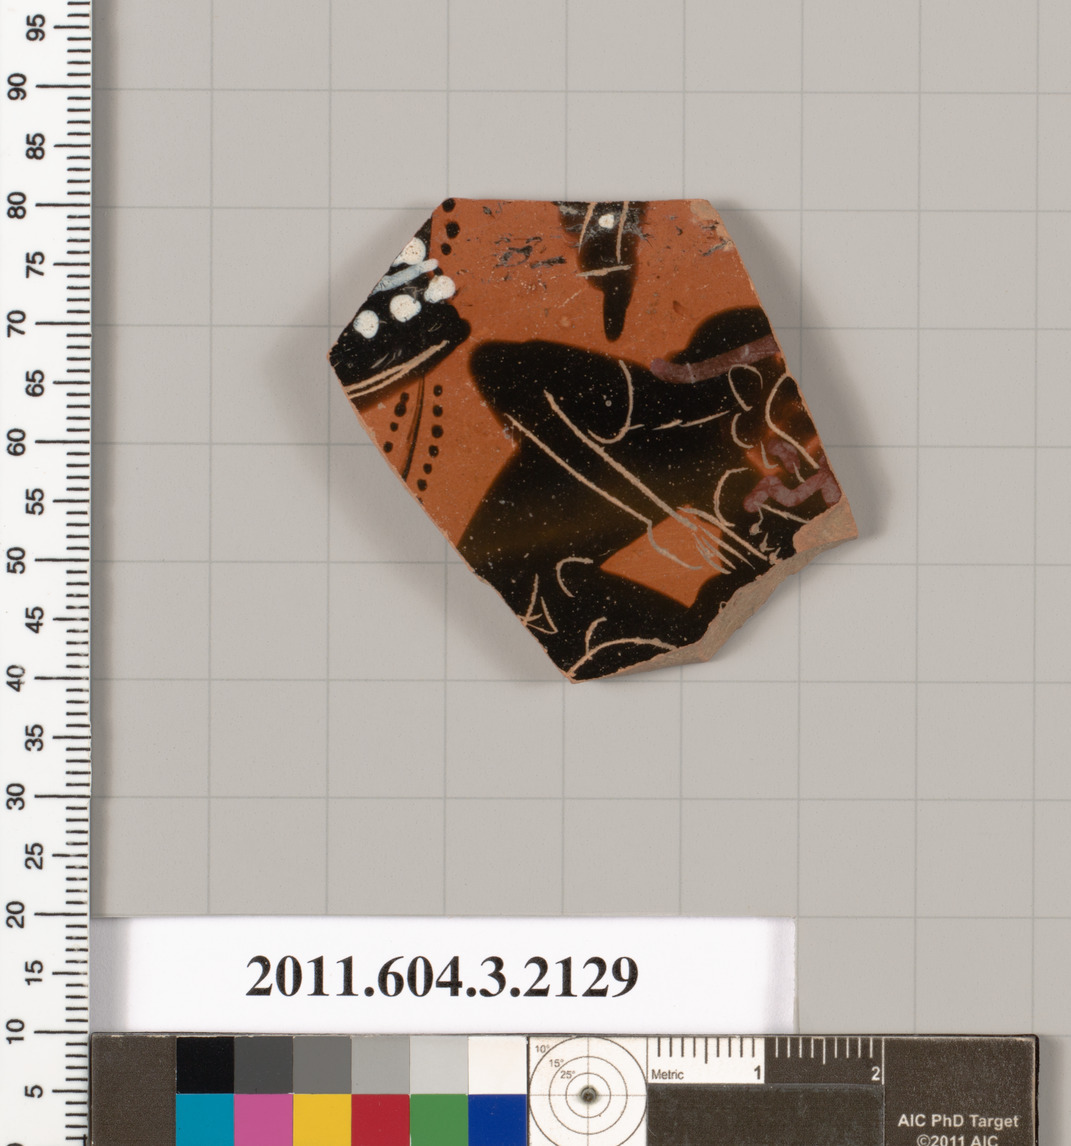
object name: kylix fragment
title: Terracotta fragment of a kylix (drinking cup)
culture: greek, attic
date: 500-468 BCE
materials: terracotta